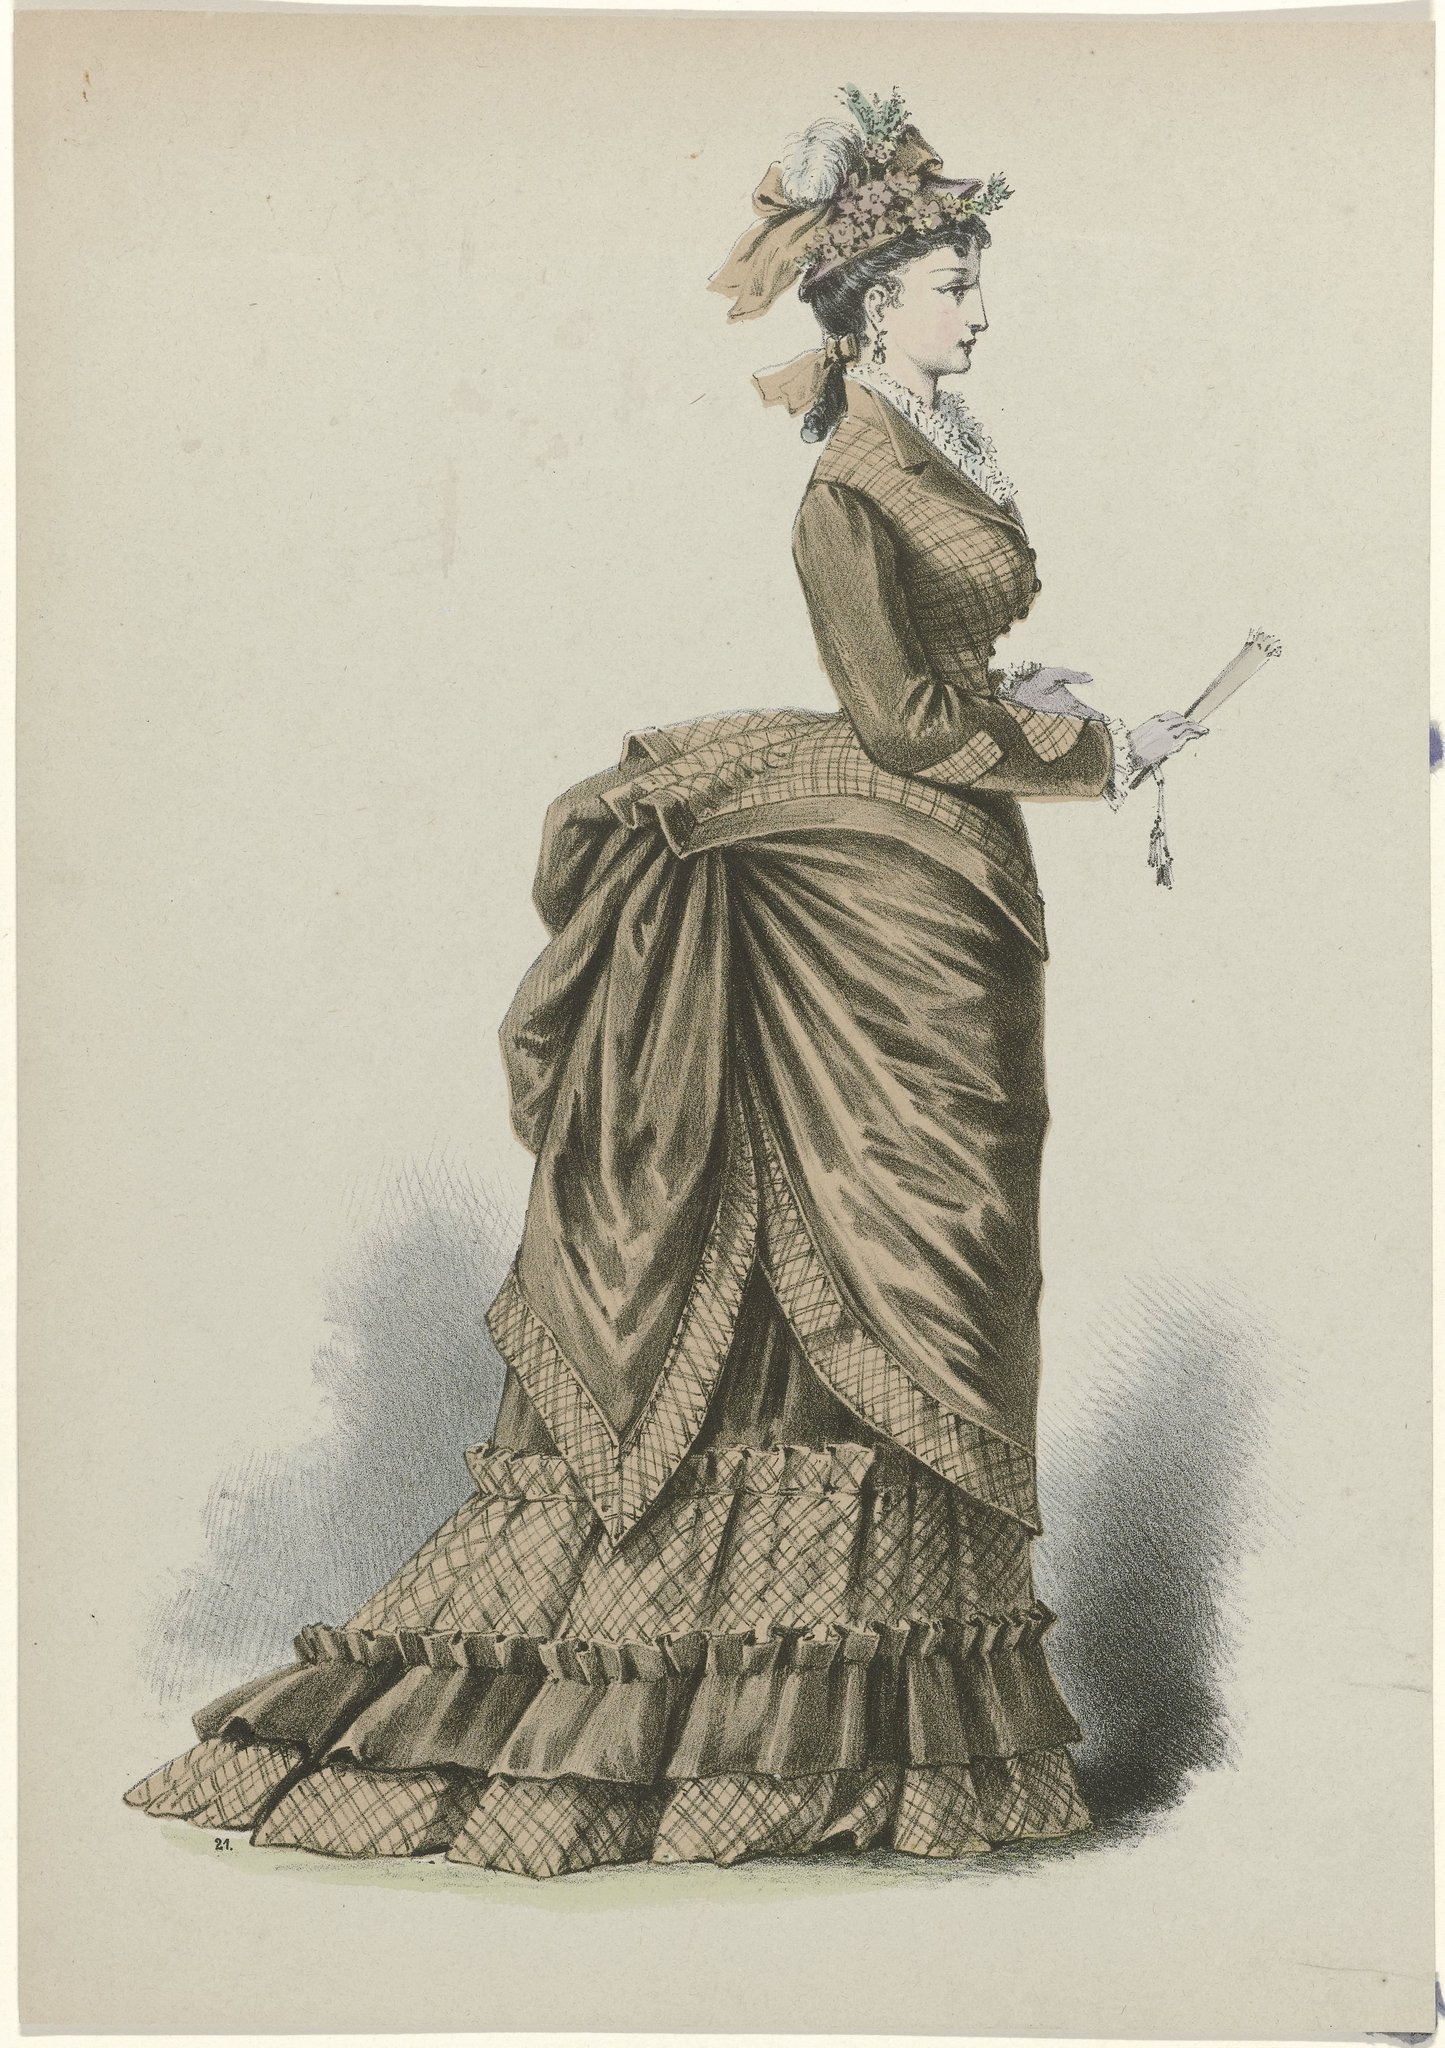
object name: fashion print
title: Vrouw met waaier, ca. 1875, No. 21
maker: Anonymous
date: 1875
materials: paper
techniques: hand coloring, lithograph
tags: ear-rings (+ women's clothes), gloves, mittens (long gloves) (+ women's clothes), head-gear (+ women's clothes), fashion plates, dress, gown (+ women's clothes), fan (+ women's clothes), neck-gear ~ clothing (+ women's clothes), sleeves (+ women's clothes)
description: Vrouw in een deels geruite japon. Getailleerd lijfje met revers, middenvoor een rij knopen, lange mouwen en schootje. Rok met queue en onderrok met sleepje. Gerimpelde kraag en manchetten. Accessoires: hoed versierd met bloemen en struisveer, oorbel, handschoenen, waaier.